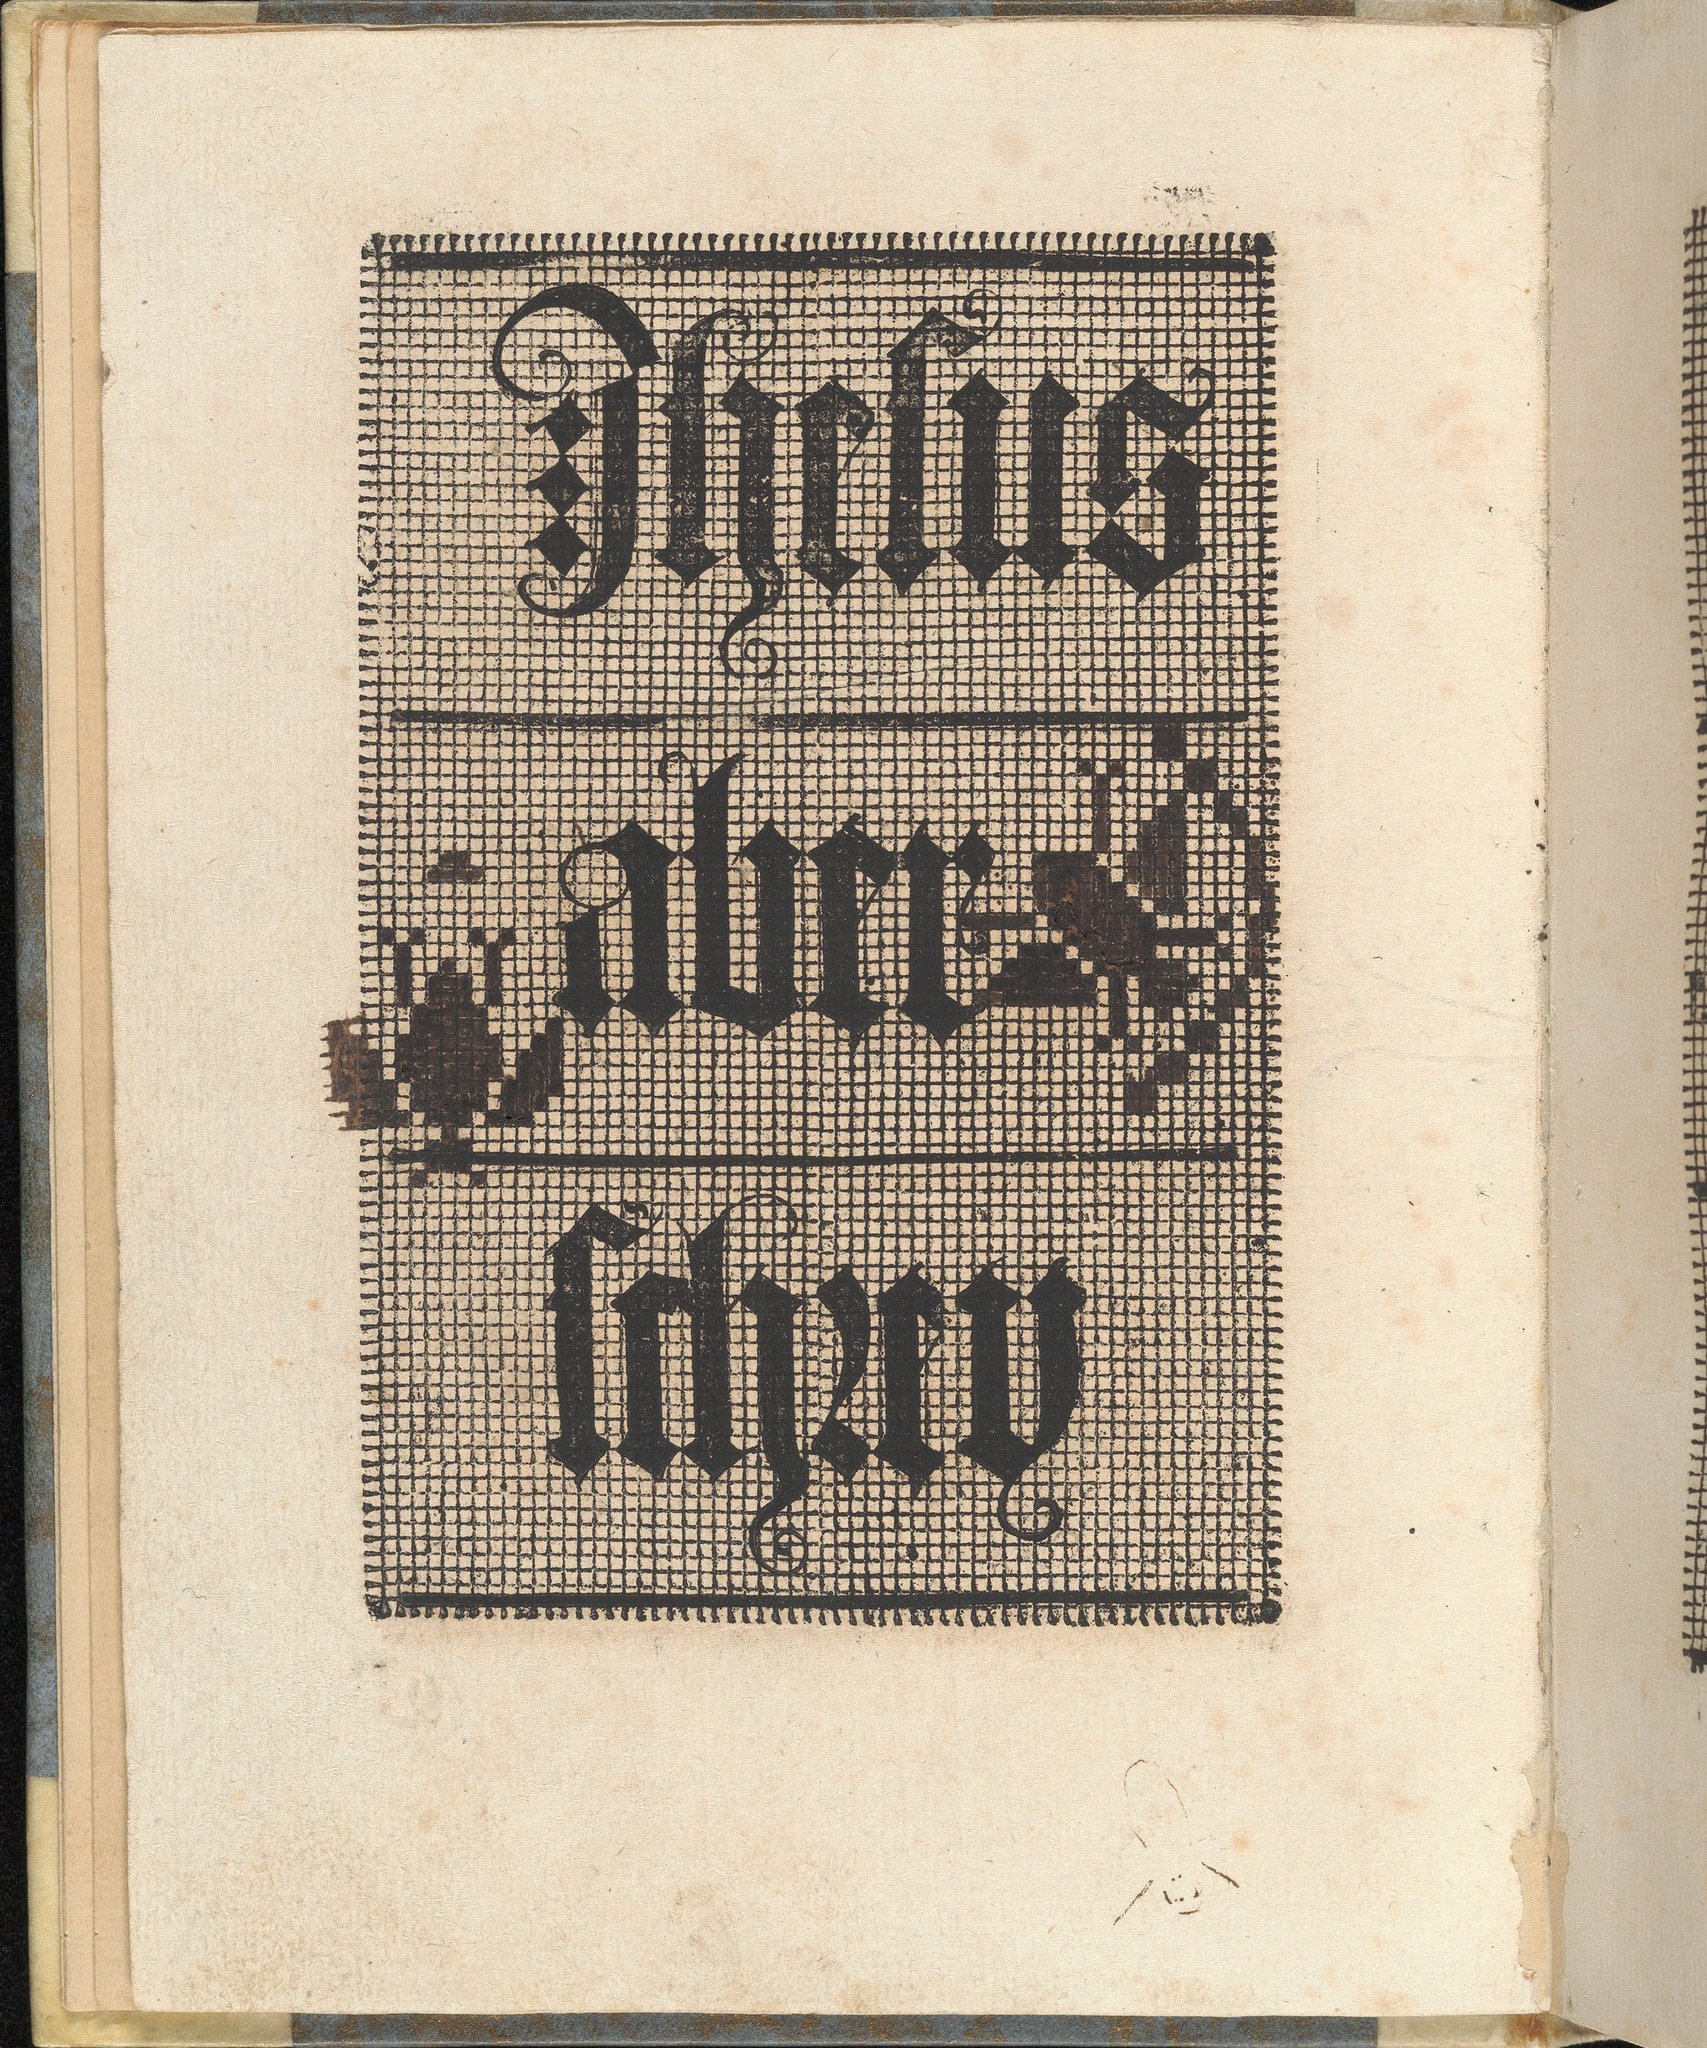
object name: book print ornament architecture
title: Ein ney Furmbüchlein, Page 7, verso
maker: johann schönsperger the younger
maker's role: publisher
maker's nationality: german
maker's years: 1490-1550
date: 1525-1529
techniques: woodcut